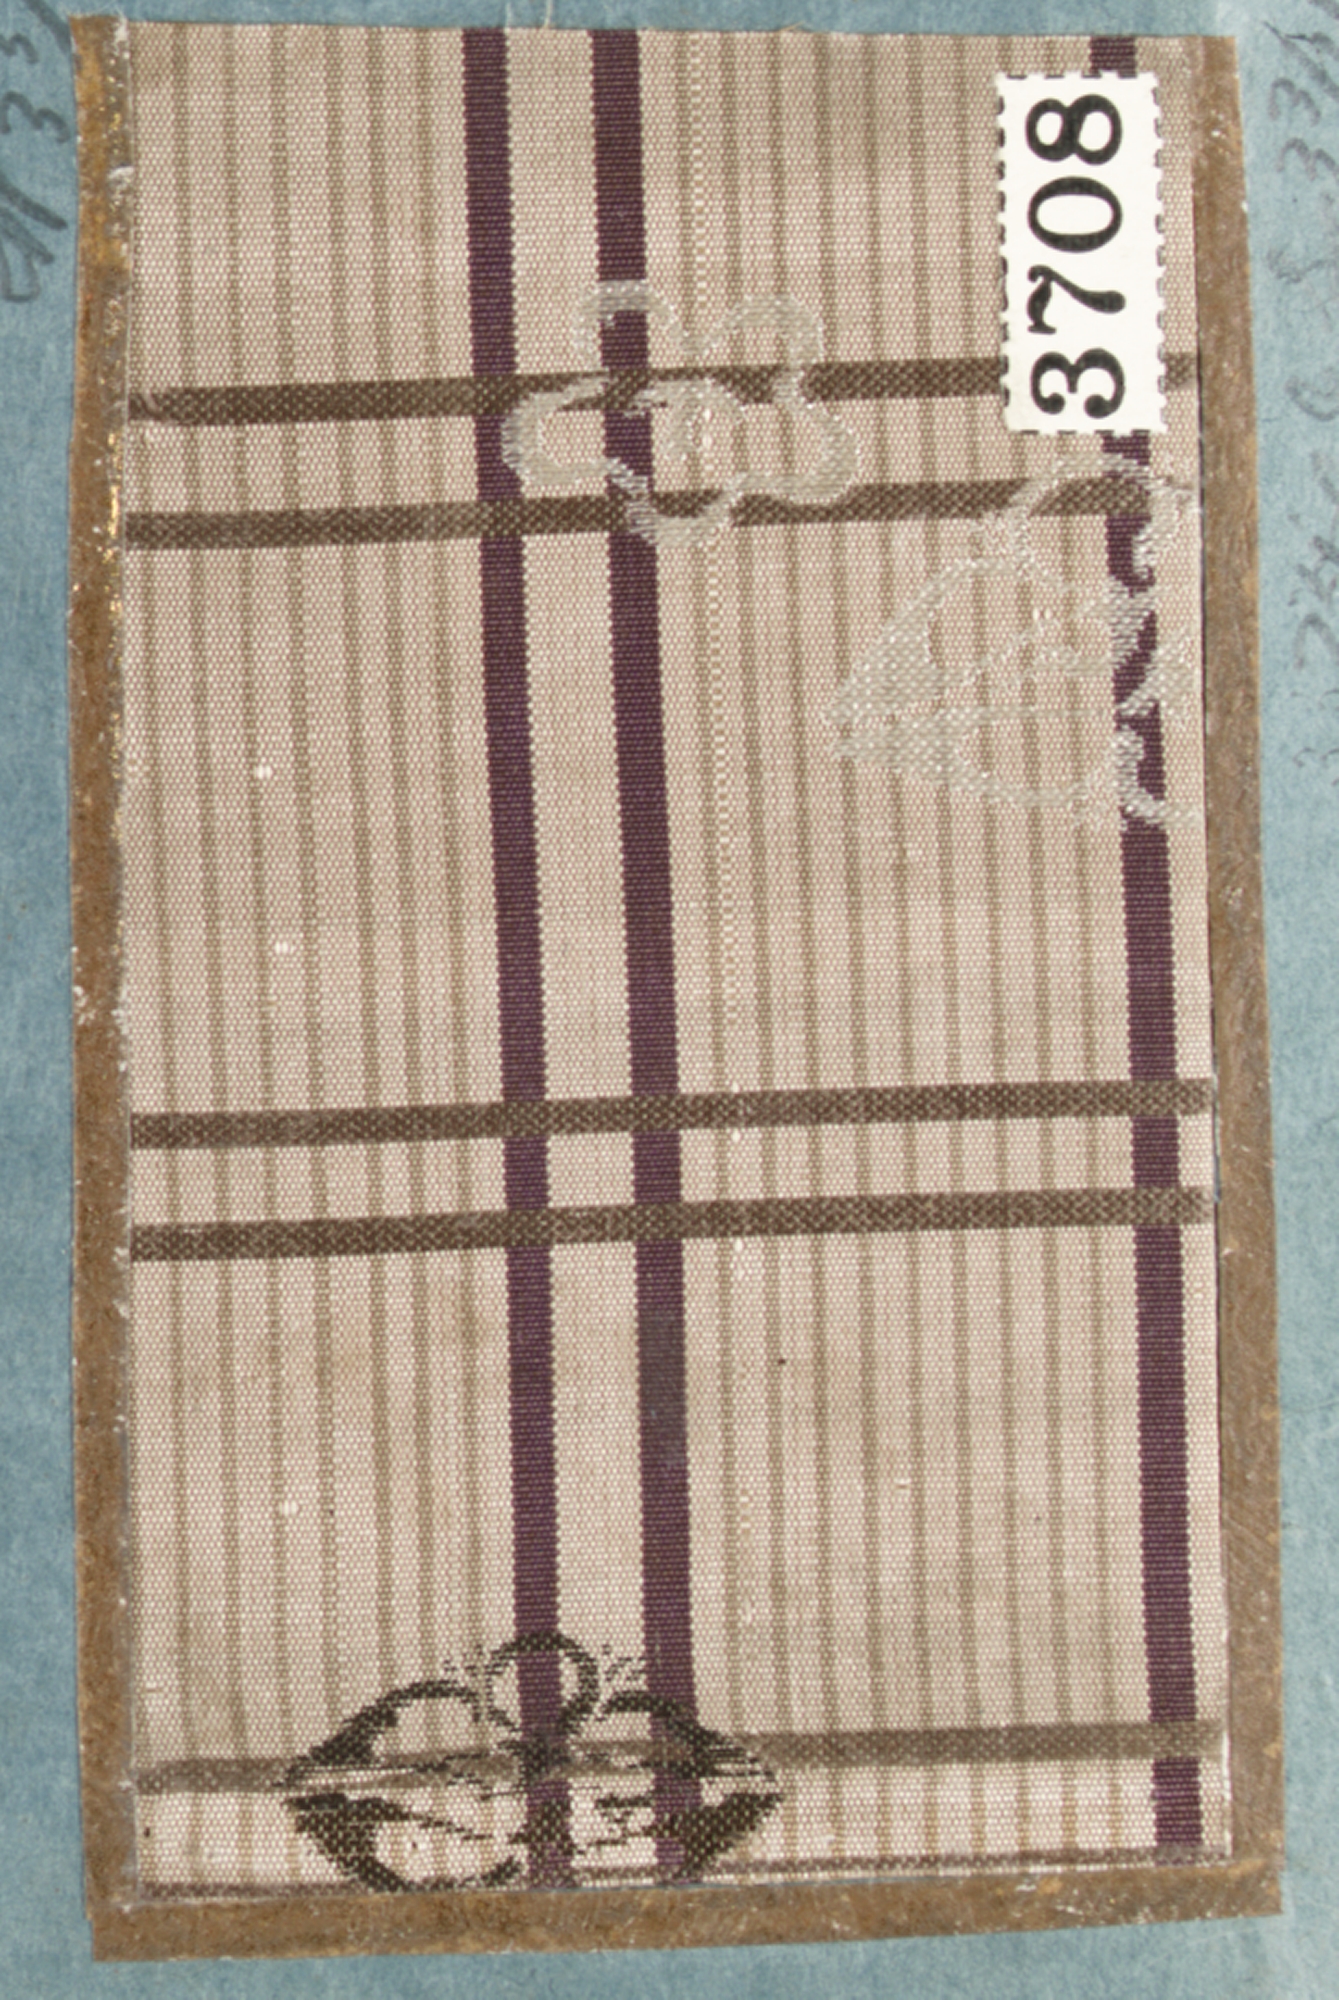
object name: sample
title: Textile Sample from Sample Book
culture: japanese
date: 1801-1900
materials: silk